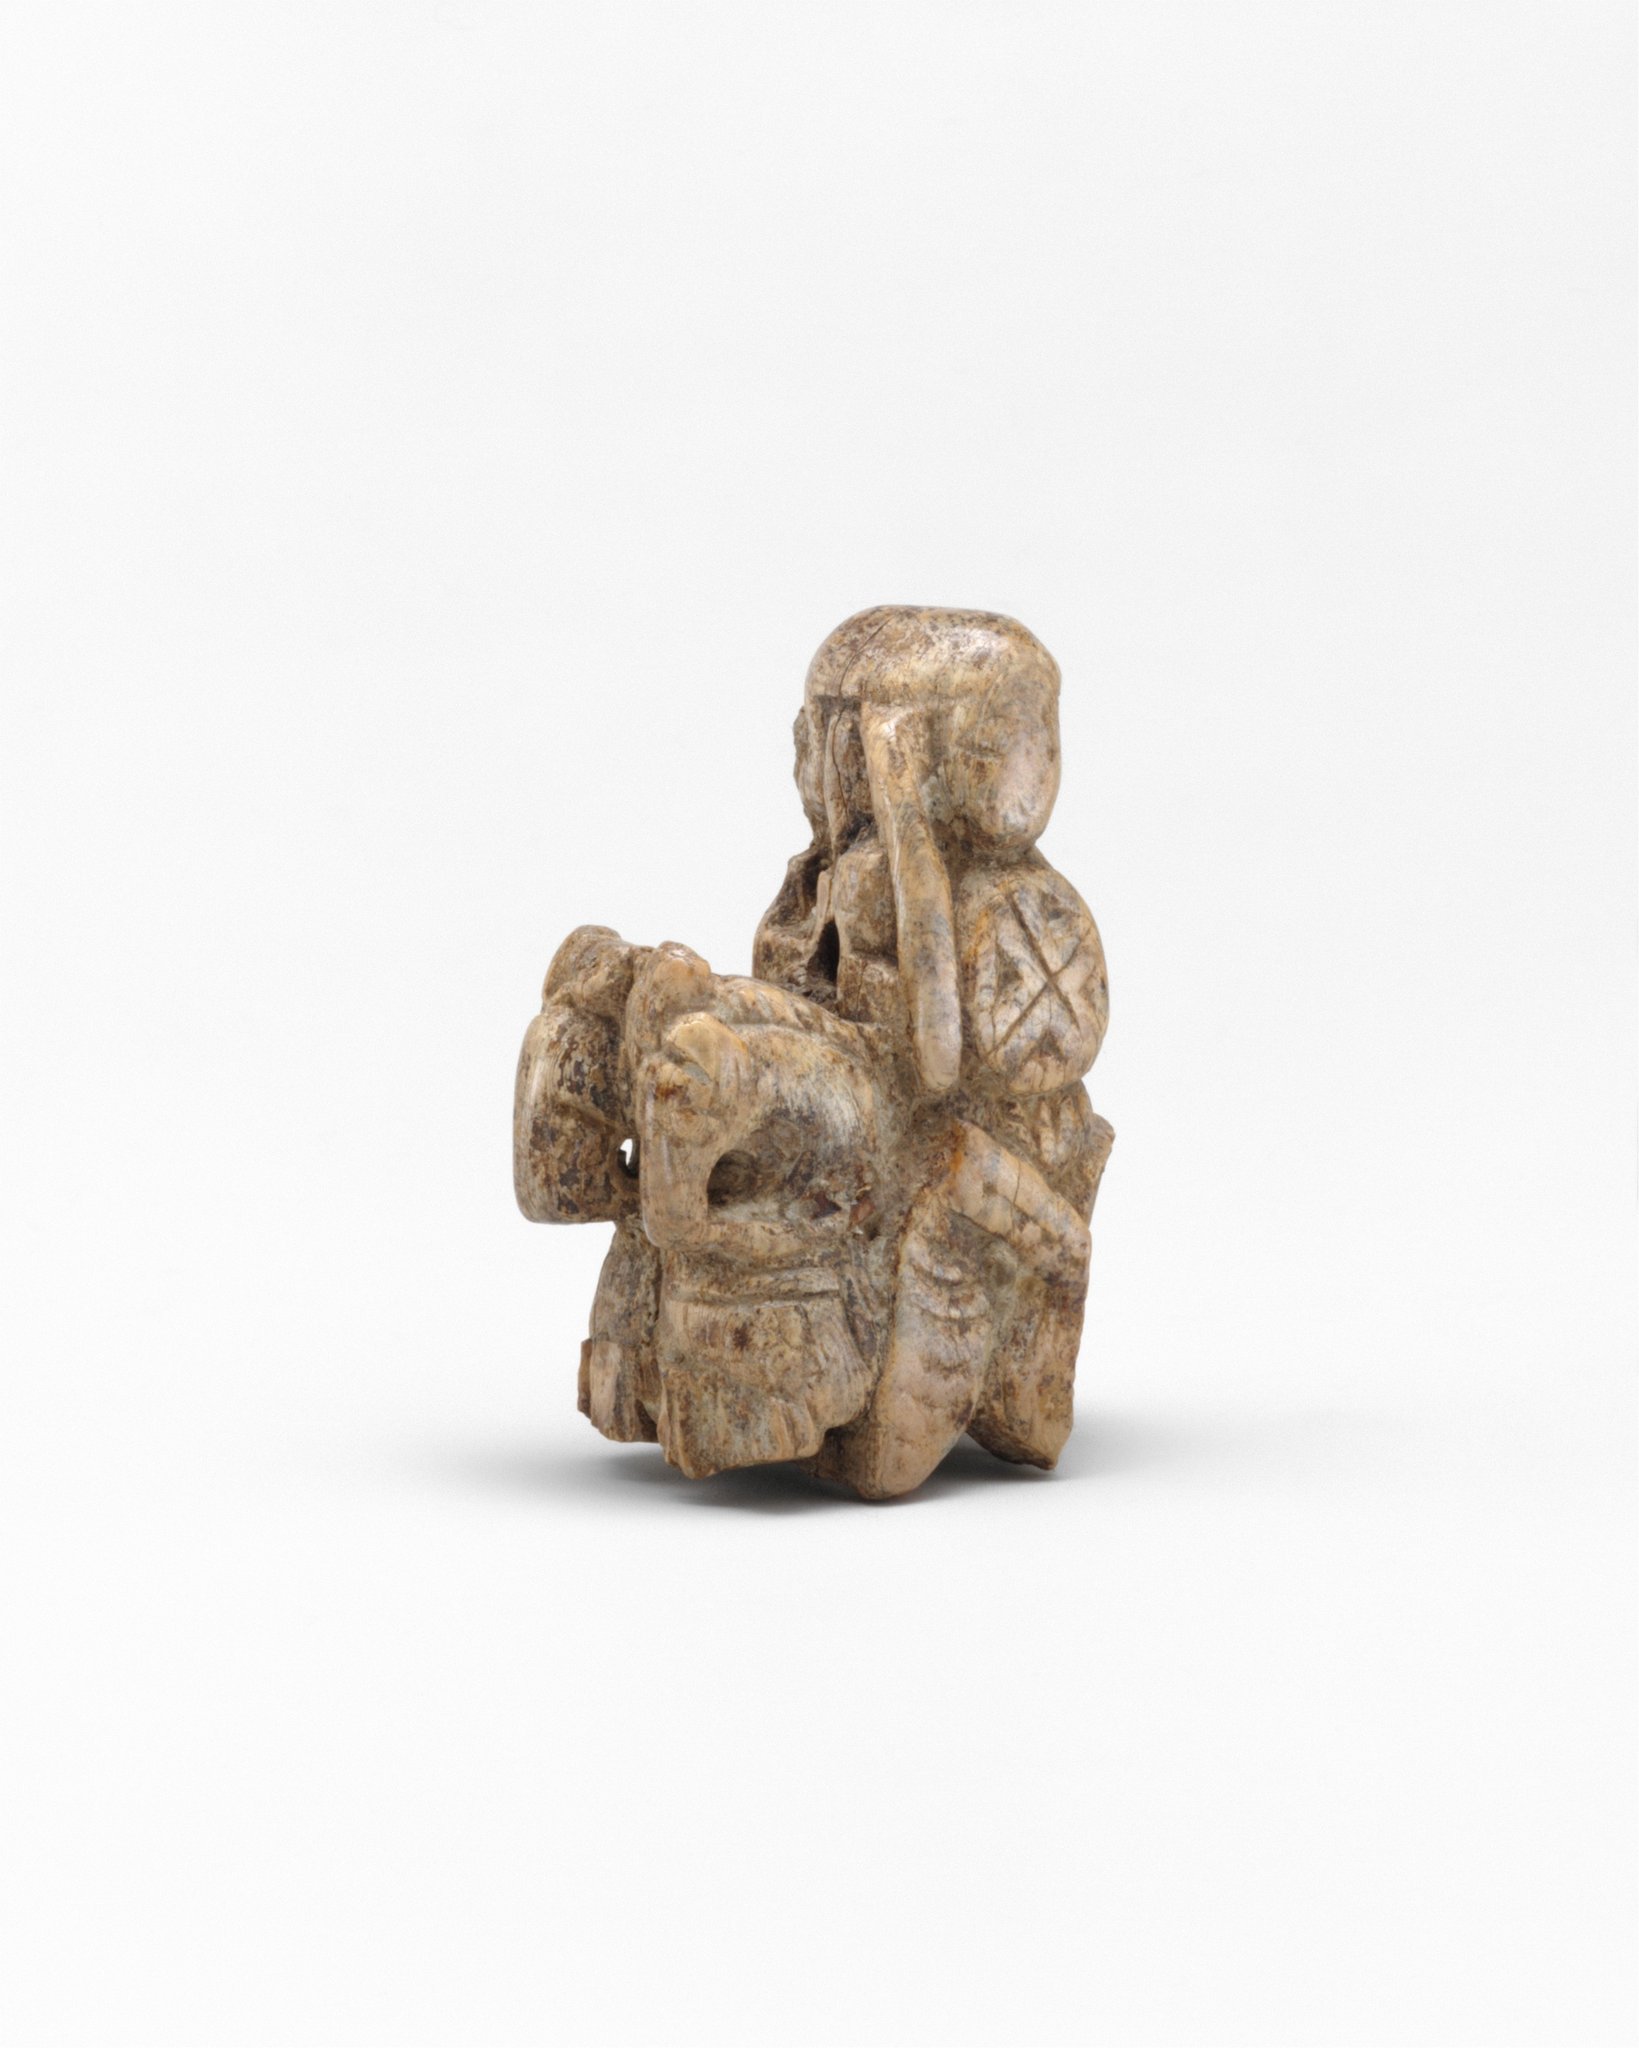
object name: chess piece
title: Chess Piece, Rook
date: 1001-1200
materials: ivory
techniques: carving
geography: western islamic lands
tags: chess